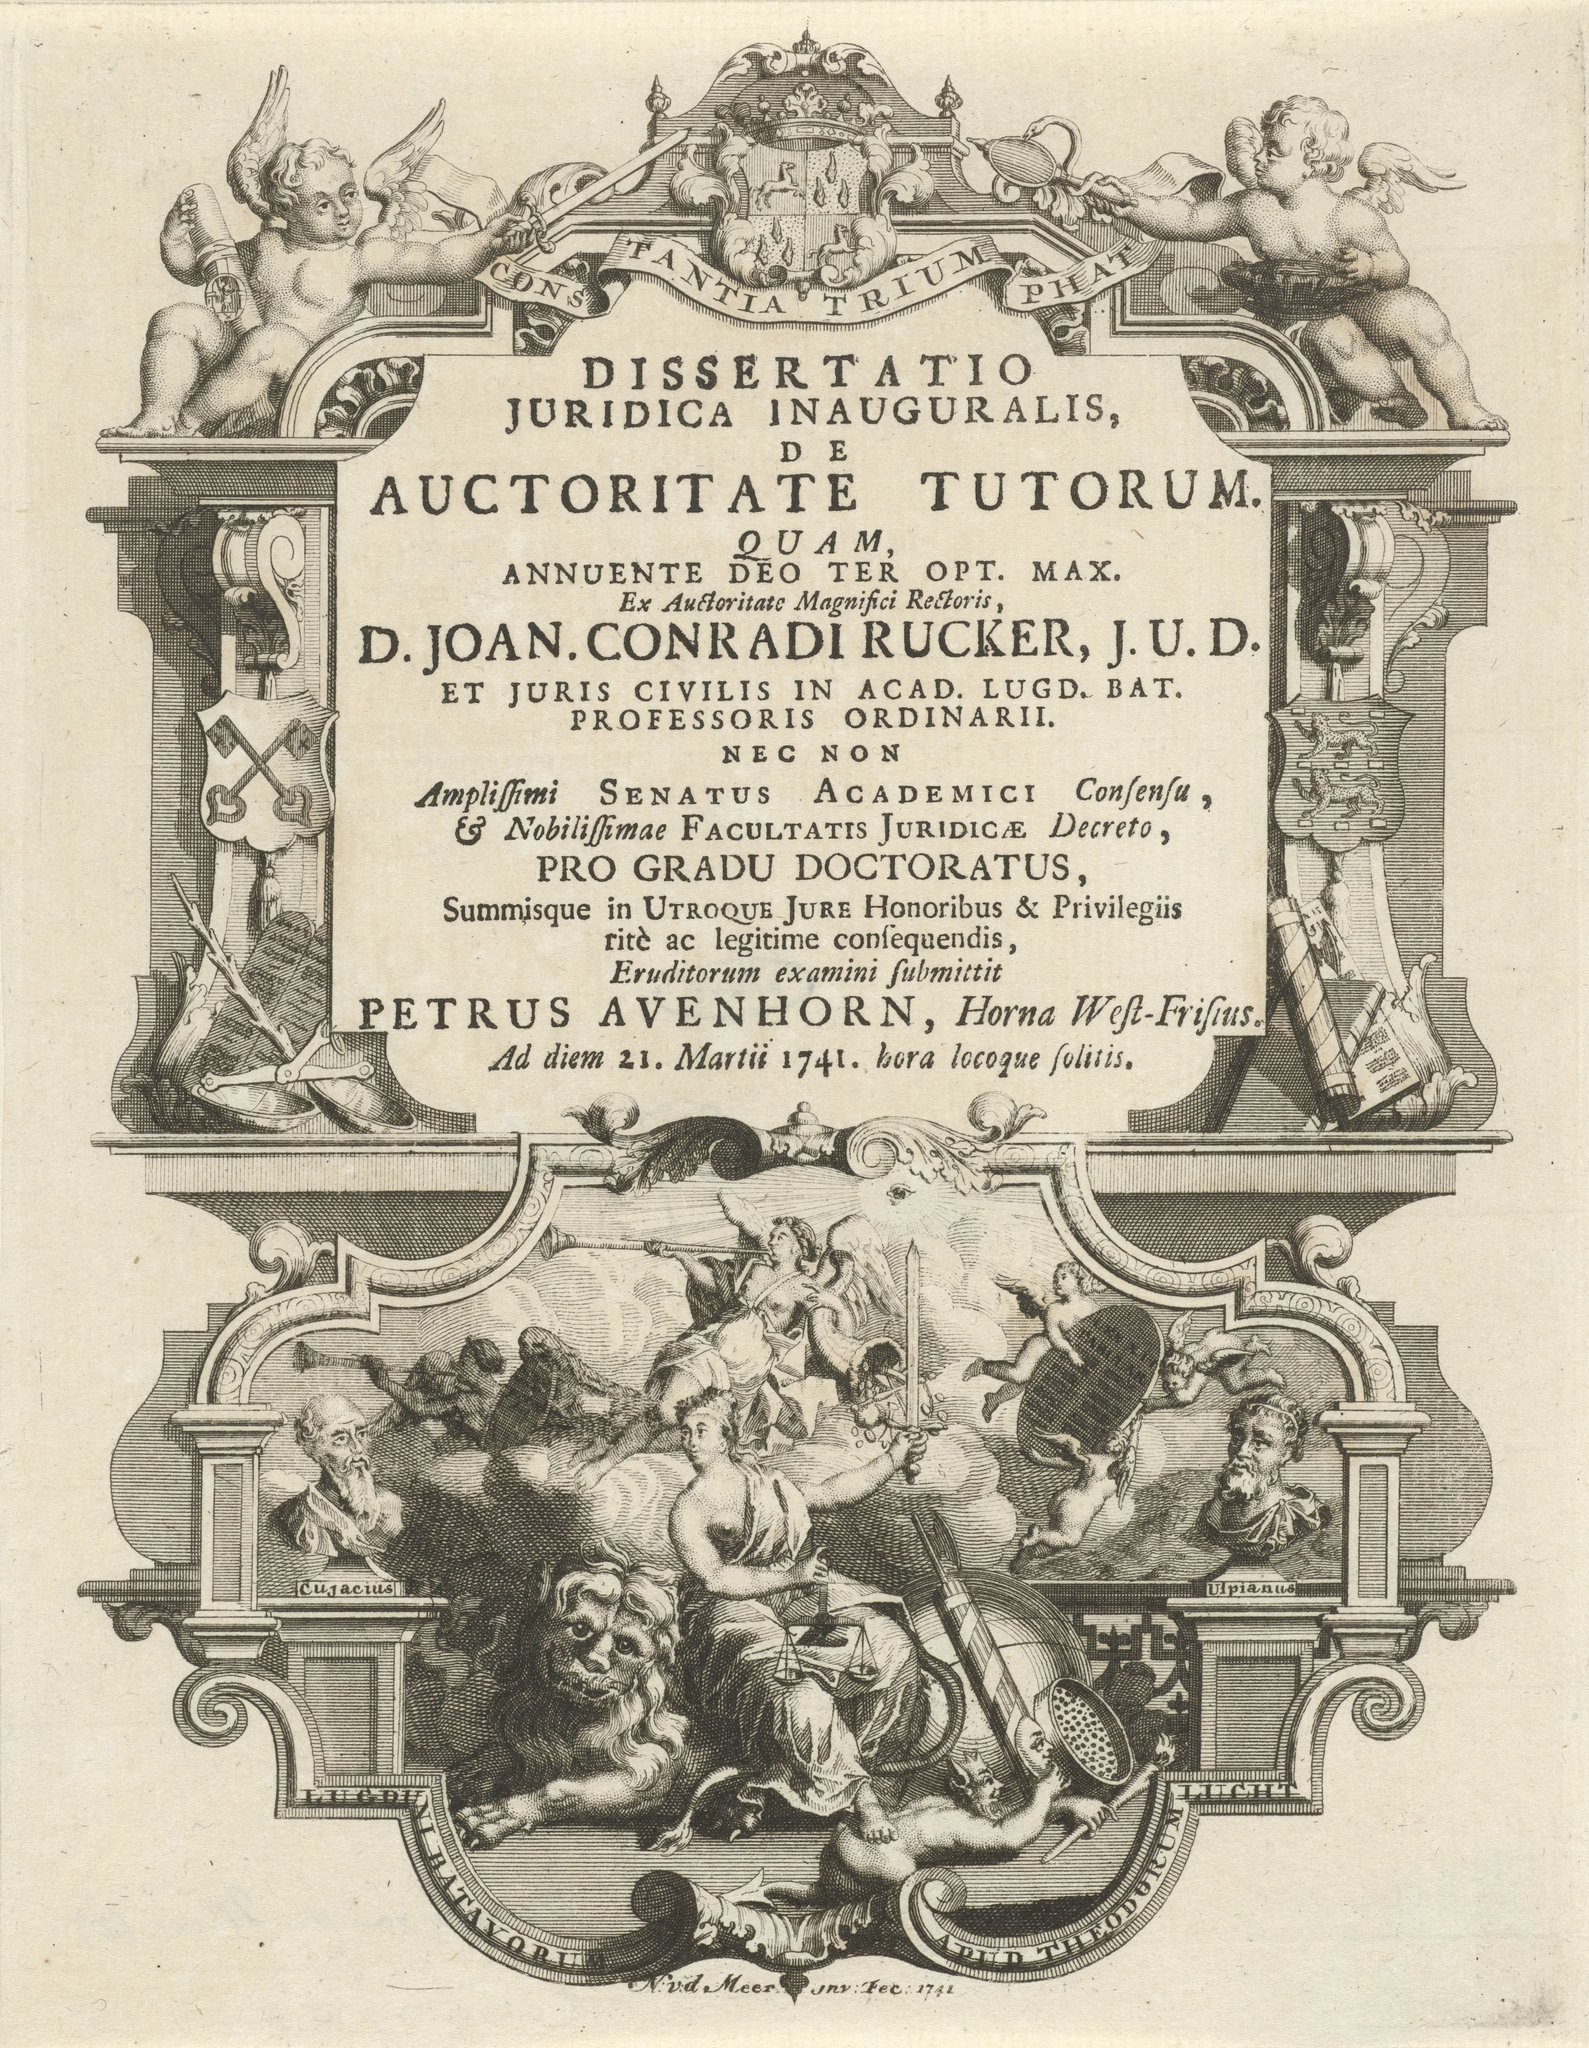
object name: print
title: Rechtvaardigheid zittend op de Hollandse leeuw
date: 1741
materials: paper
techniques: etching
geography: leiden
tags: fame; 'fama', 'fama buona', 'fama chiara' (ripa), beasts of prey, predatory animals: lion, justice, 'justitia'; 'giustitia divina' (ripa) ~ one of the four cardinal virtues - mm - triumph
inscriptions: collector's mark: Lugt 2228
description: Ornamentele omlijsting bekroond door een wapenschild en twee putti, de één met het zwaard van rechtvaardigheid, de ander met de spiegel en slang van voorzichtigheid. Links het wapenschild van Leiden. Onderaan blaast Faam op de trompet en houdt een hoorn des overvloeds onder haar arm. Voor haar zit Rechtvaardigheid op de Hollandse leeuw. Links en rechts de borstbeelden van twee geleerden.